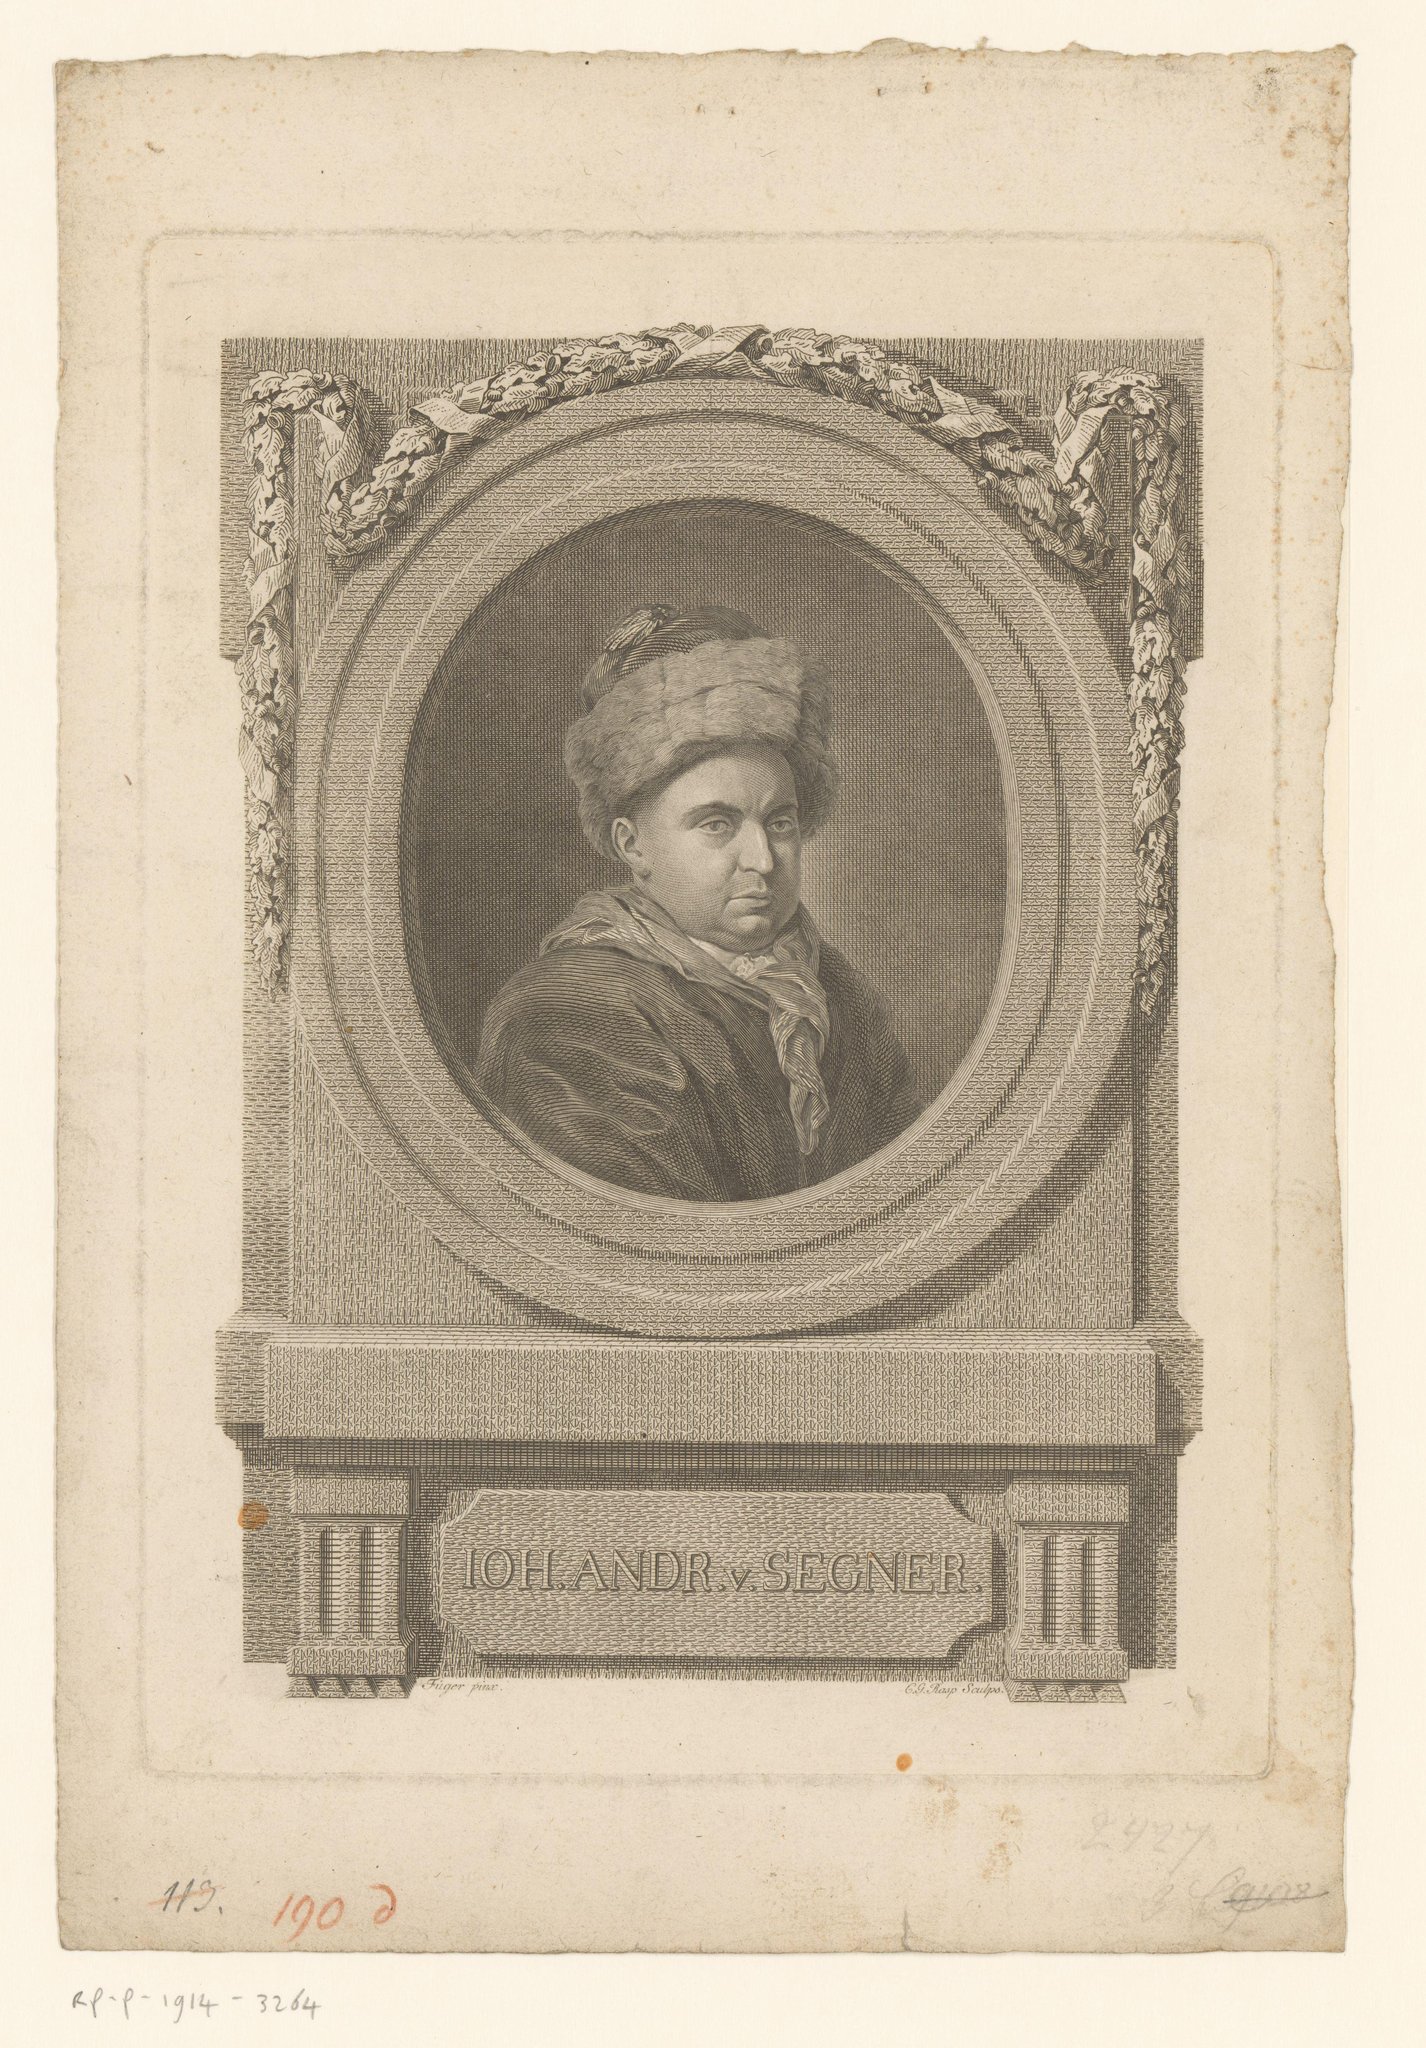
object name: print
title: Portret van Johann Andreas von Segner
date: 1762-1807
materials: paper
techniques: engraving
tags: historical persons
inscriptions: collector's mark: Lugt 2228